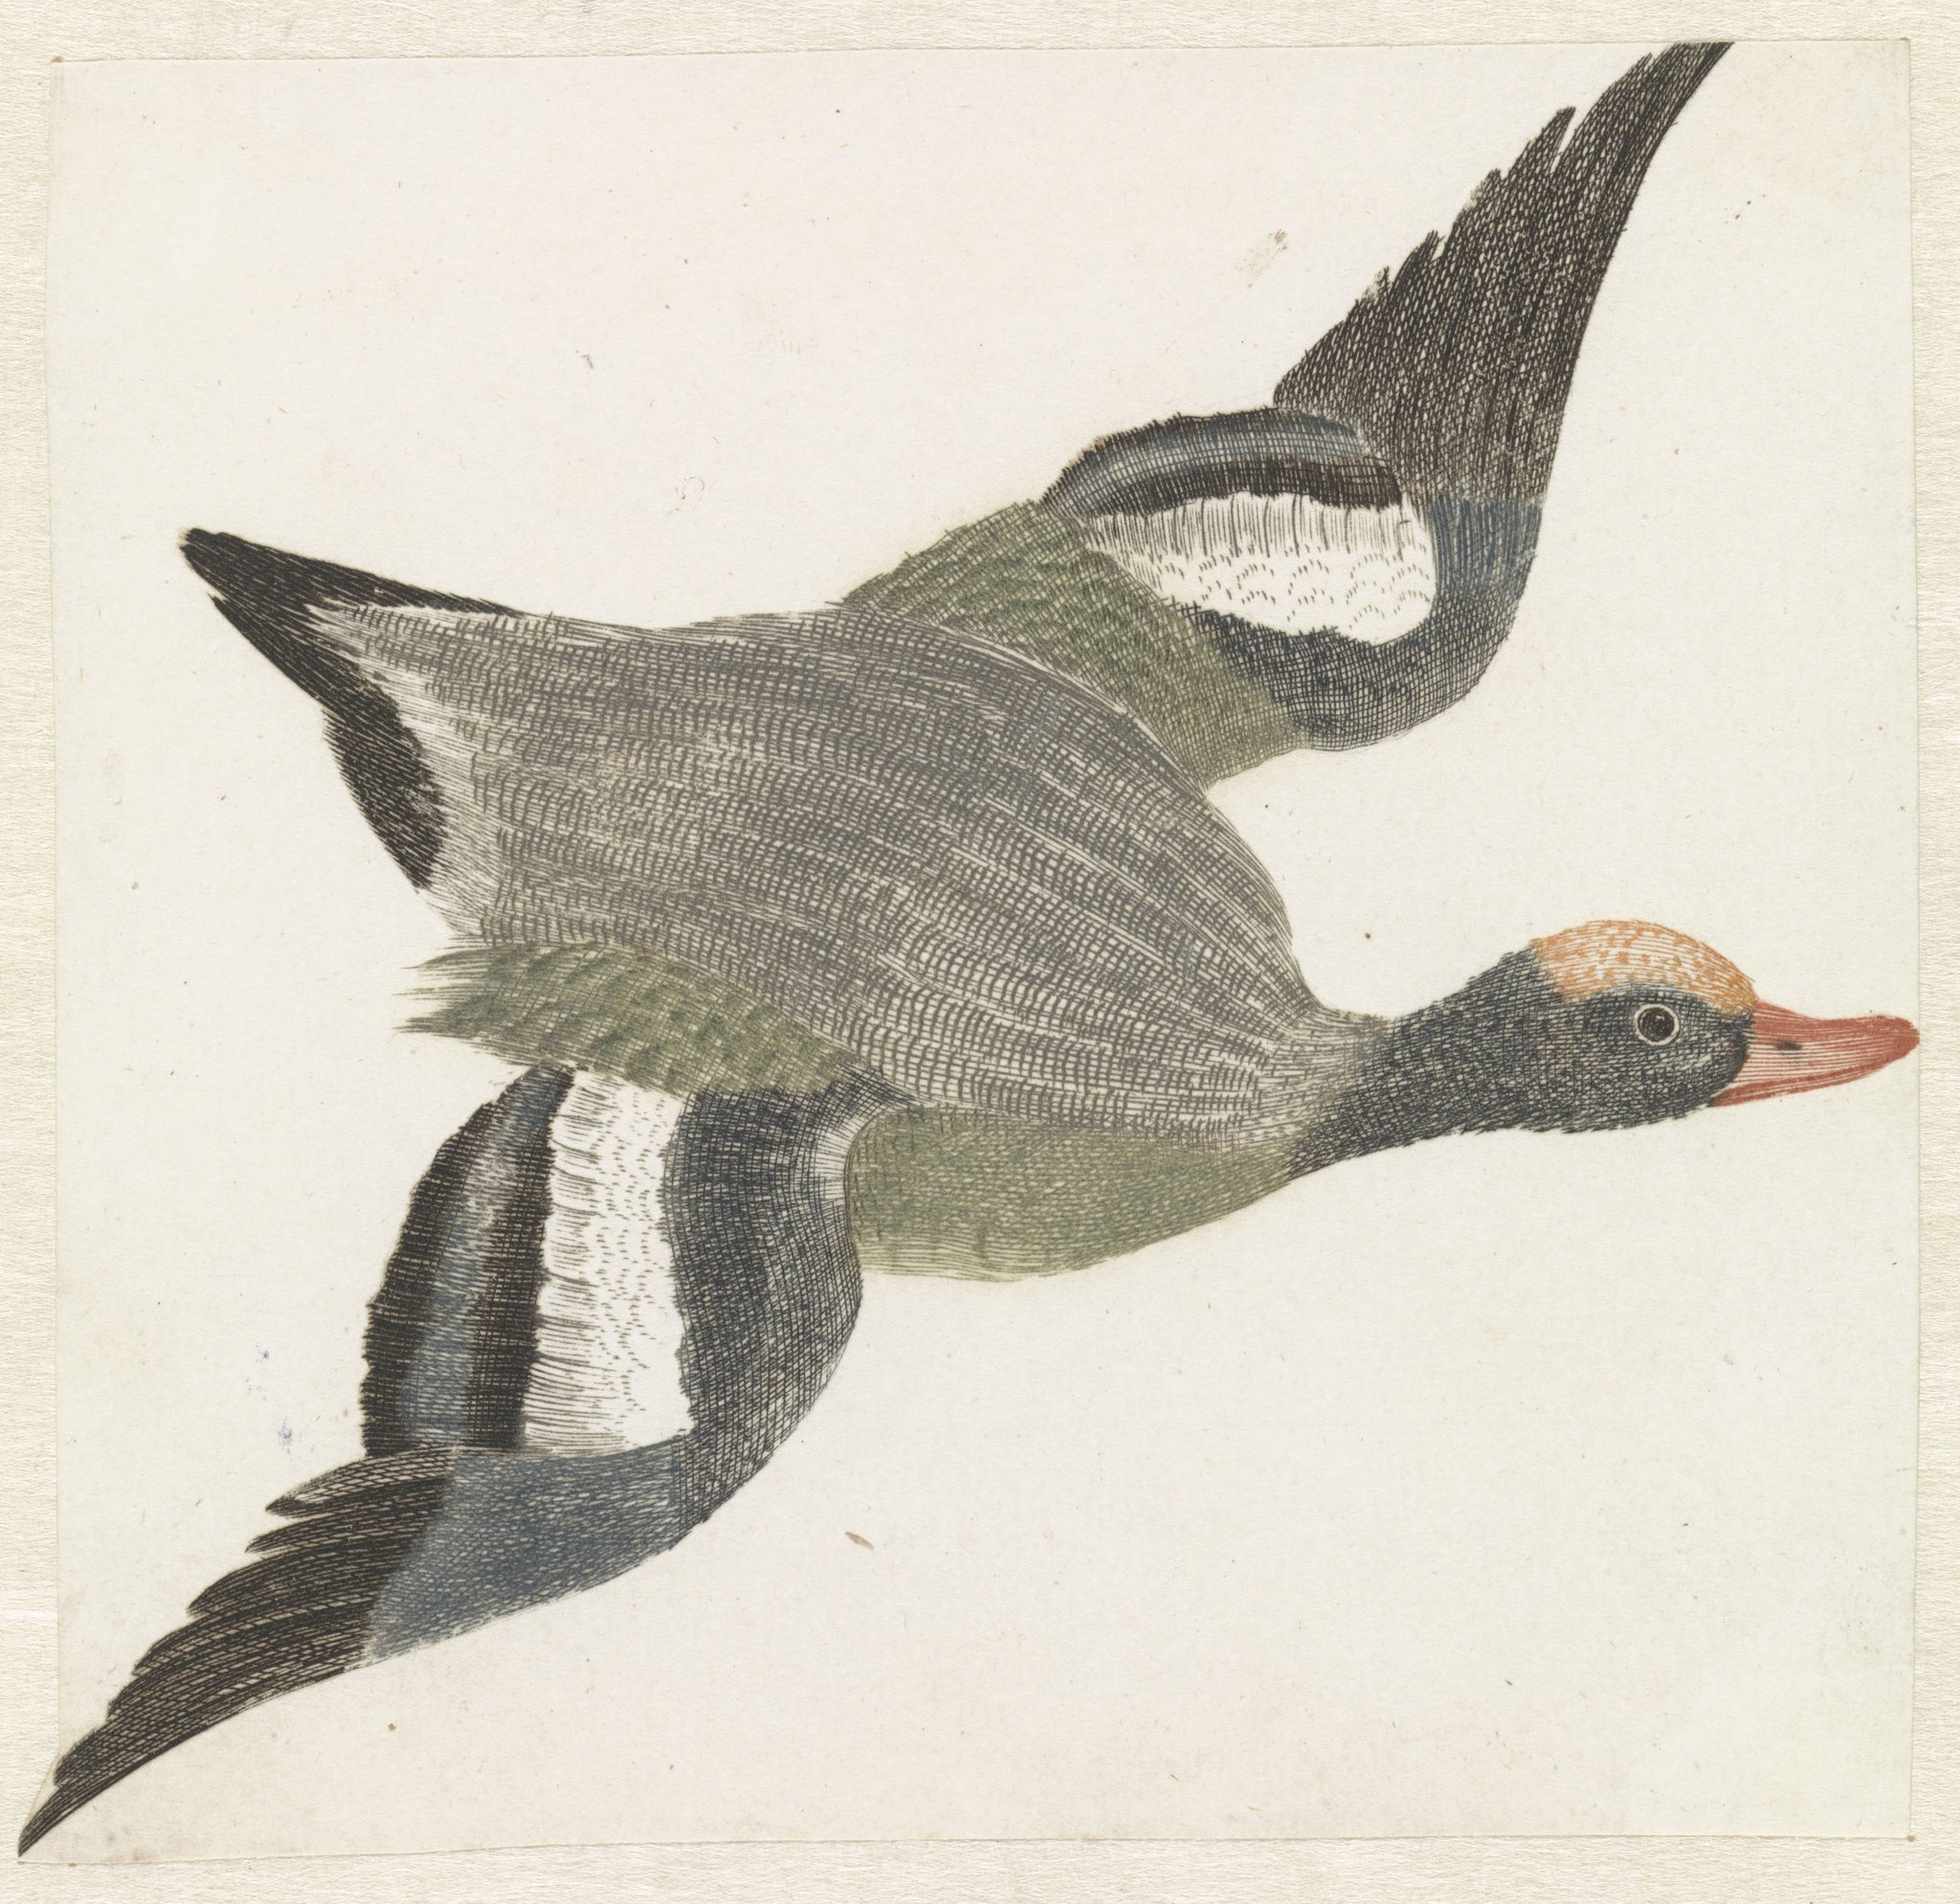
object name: print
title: Naar rechts vliegende smient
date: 1688-1698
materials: paper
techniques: printing, engraving, lithography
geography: netherlands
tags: water-birds: duck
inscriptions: collector's mark: Lugt 2228